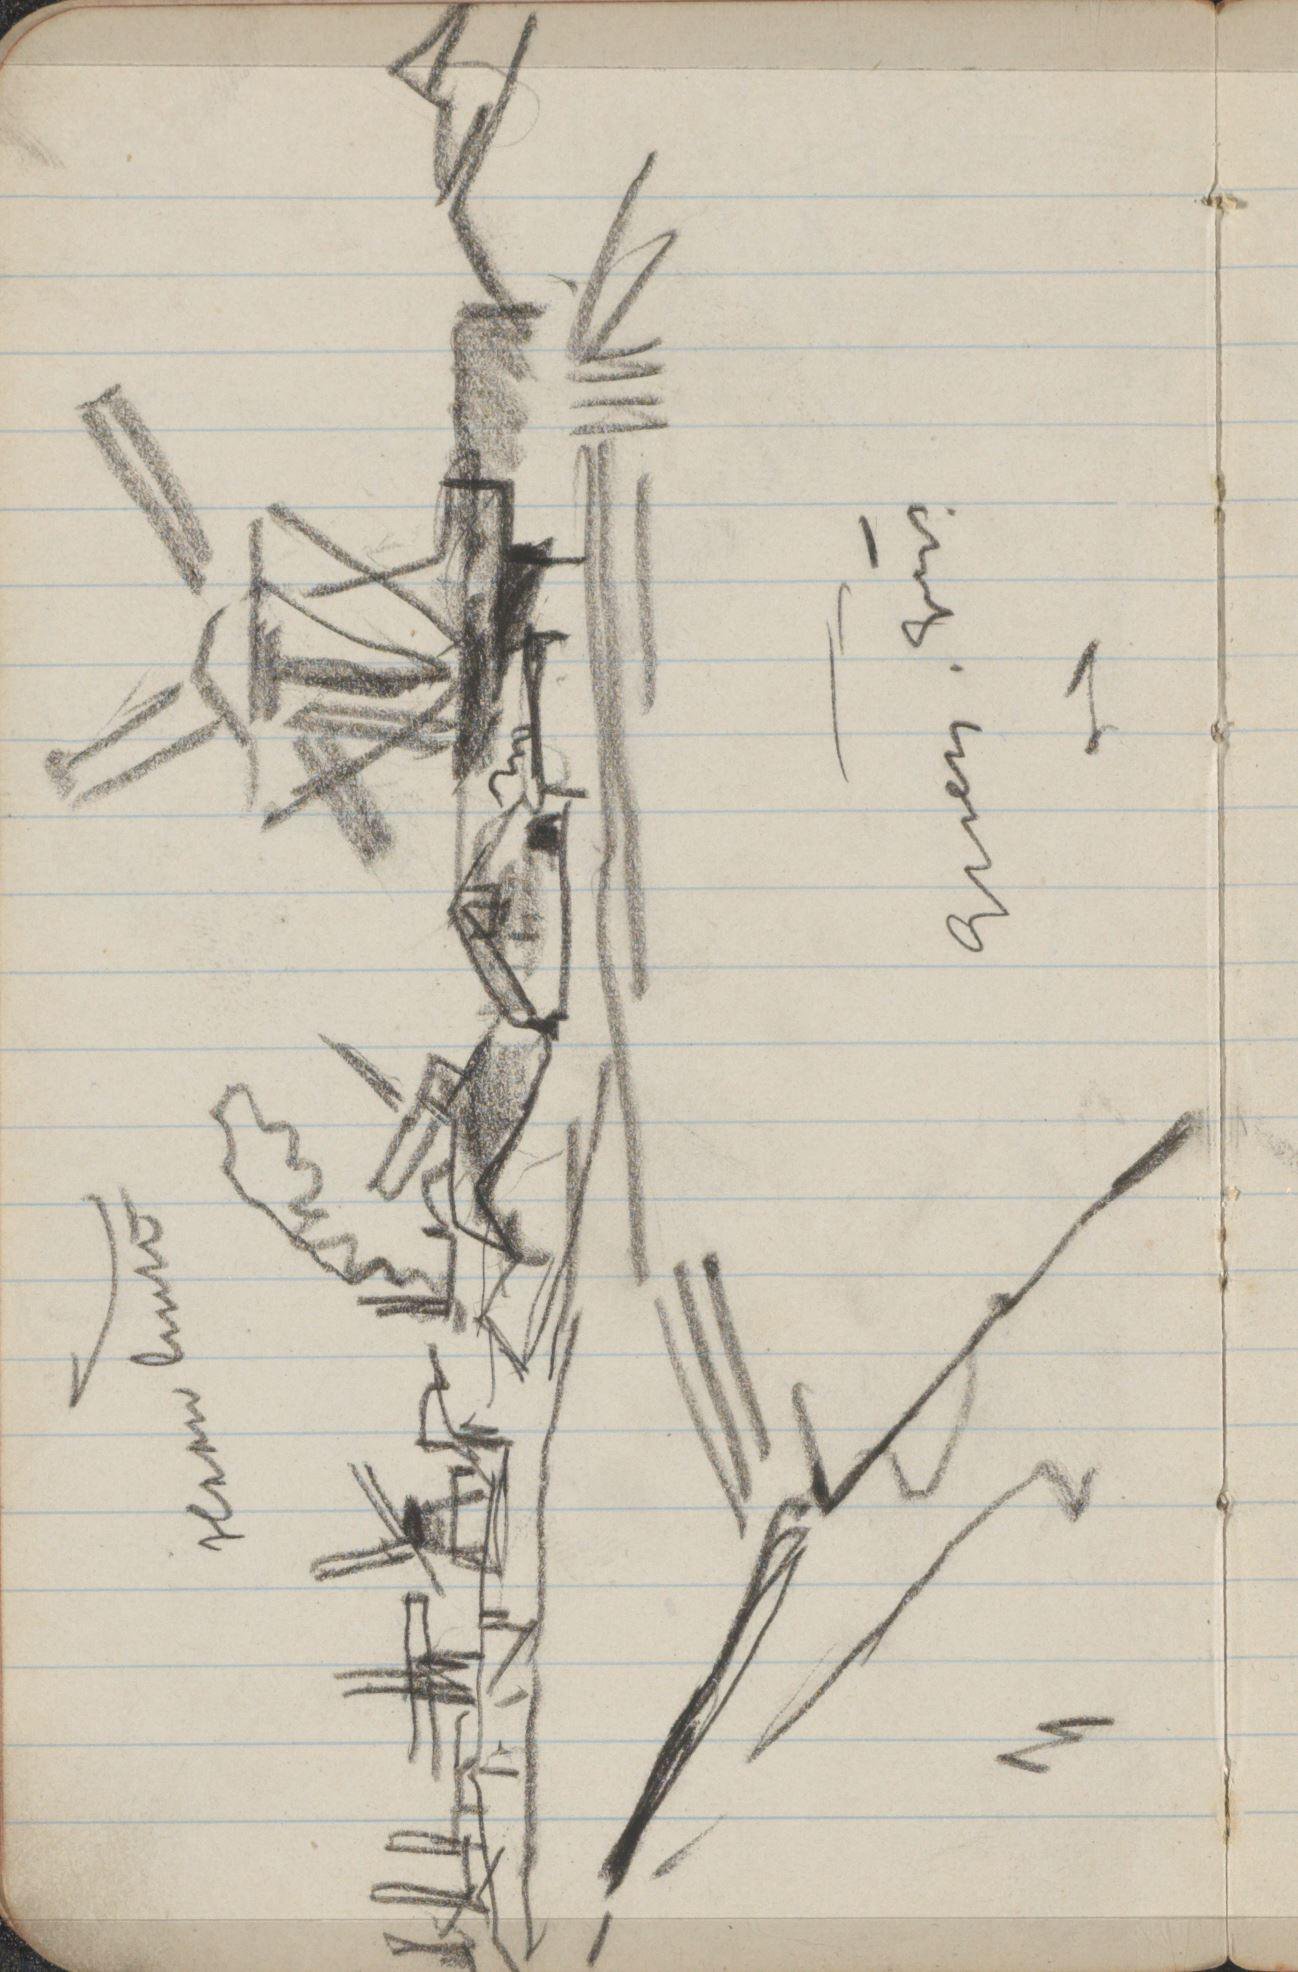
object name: sketchbook leaf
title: Gezicht op molens langs de Ringvaart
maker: george hendrik breitner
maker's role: draughtsman, painter, print maker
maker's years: 1857-1923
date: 1893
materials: chalk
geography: amsterdam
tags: landscapes with waters, waterscapes, seascapes (in the temperate zone), windmill in landscape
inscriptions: kleurnotitie, handgeschreven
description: Pagina 19 uit een schetsboek met 38 bladen.